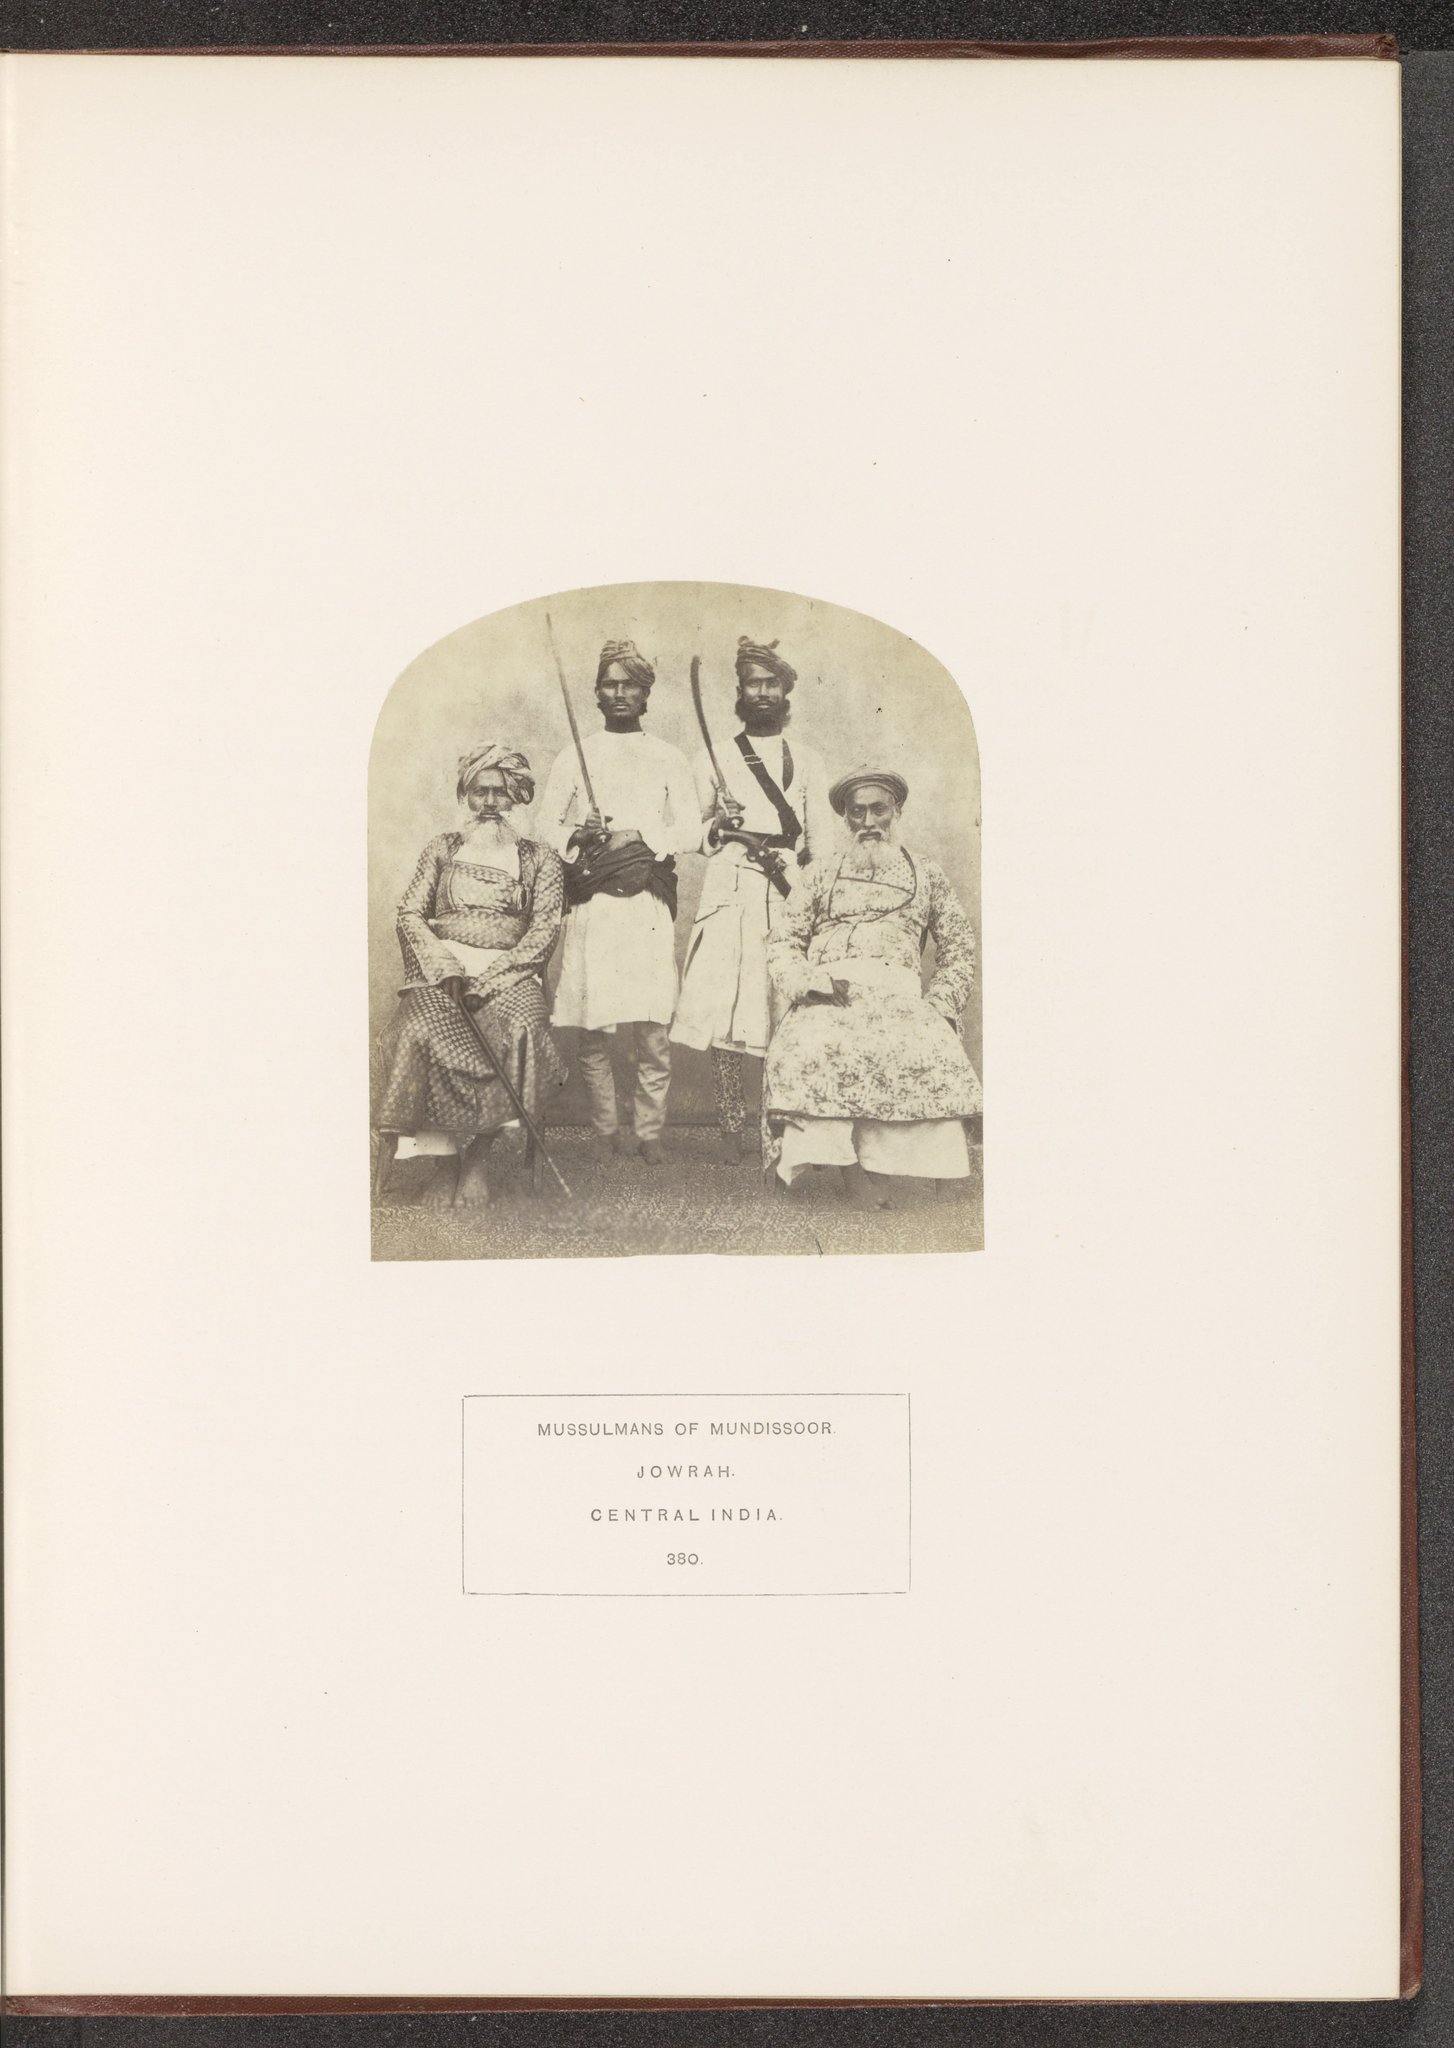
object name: photograph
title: Portrait of four unknown Islamic men from Jaora, Madhya Pradesh, India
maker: james john waterhouse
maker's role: fotograaf, luitenant, officier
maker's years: 1842-1928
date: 1862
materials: photographic support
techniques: albumen print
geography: jaora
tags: firearms: rifle, human races; peoples; nationalities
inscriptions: number: ‘380.’, inscription: ‘MUSSULMANS OF MUNDISSOOR./ JOWRAH./ CENTRAL INDIA.’